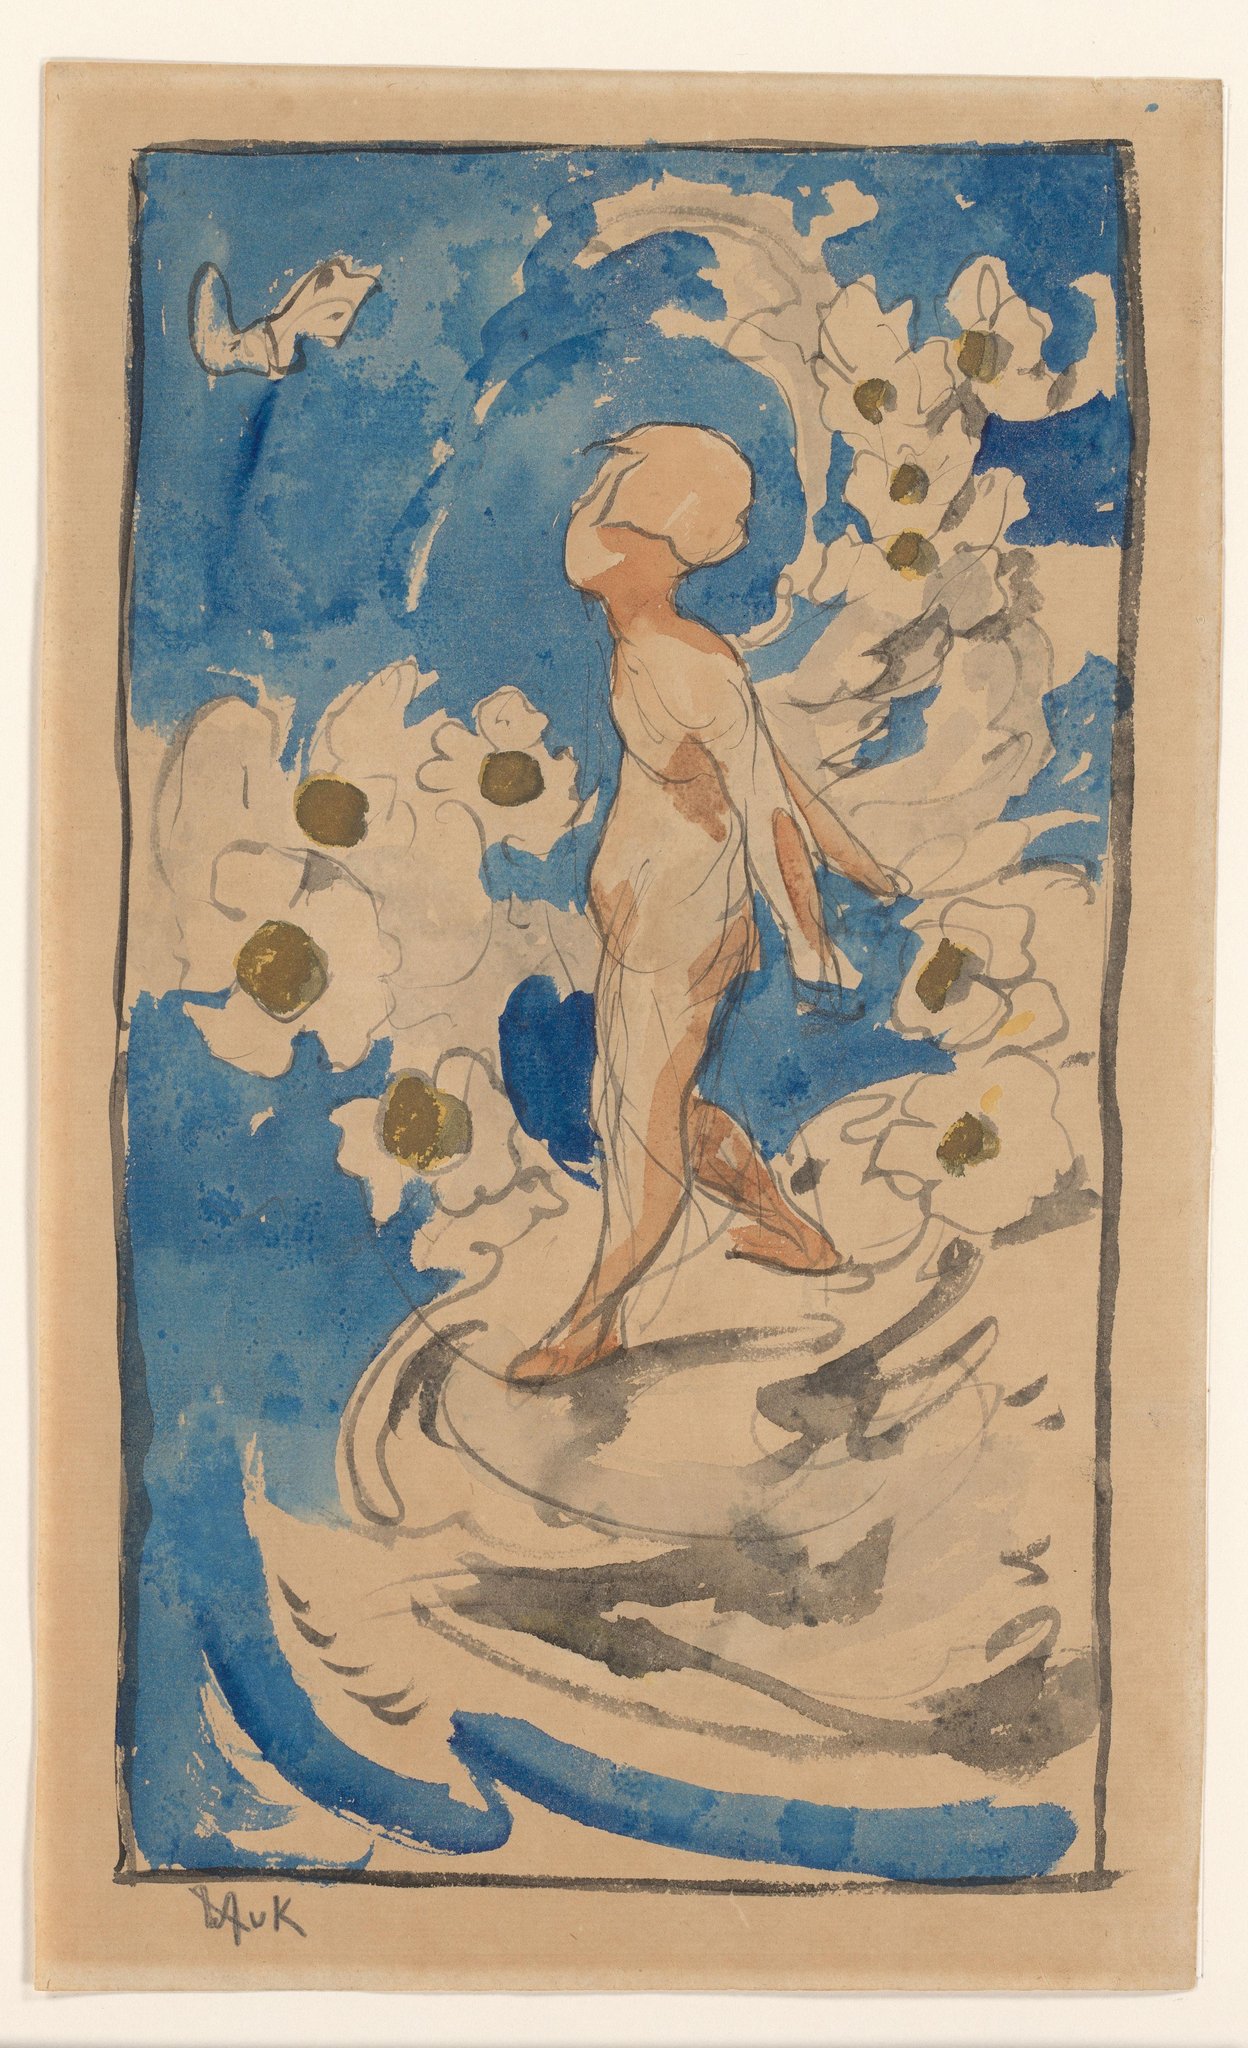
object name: drawing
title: Kleine Johannes en Windekind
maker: willem van konijnenburg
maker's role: draughtsman, painter, print maker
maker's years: 1868-1943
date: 1878-1887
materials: ink, paper, watercolor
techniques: brush, pen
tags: male literary characters (kleine johannes)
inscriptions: monogram: ‘WA v K’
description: In: Krabbels en kapitale tekeningen, nr. 236. Boekillustratie voor Frederik van Eeden, De kleine Johannes (gepubliceerd in 1887, maar niet met deze illustratie).